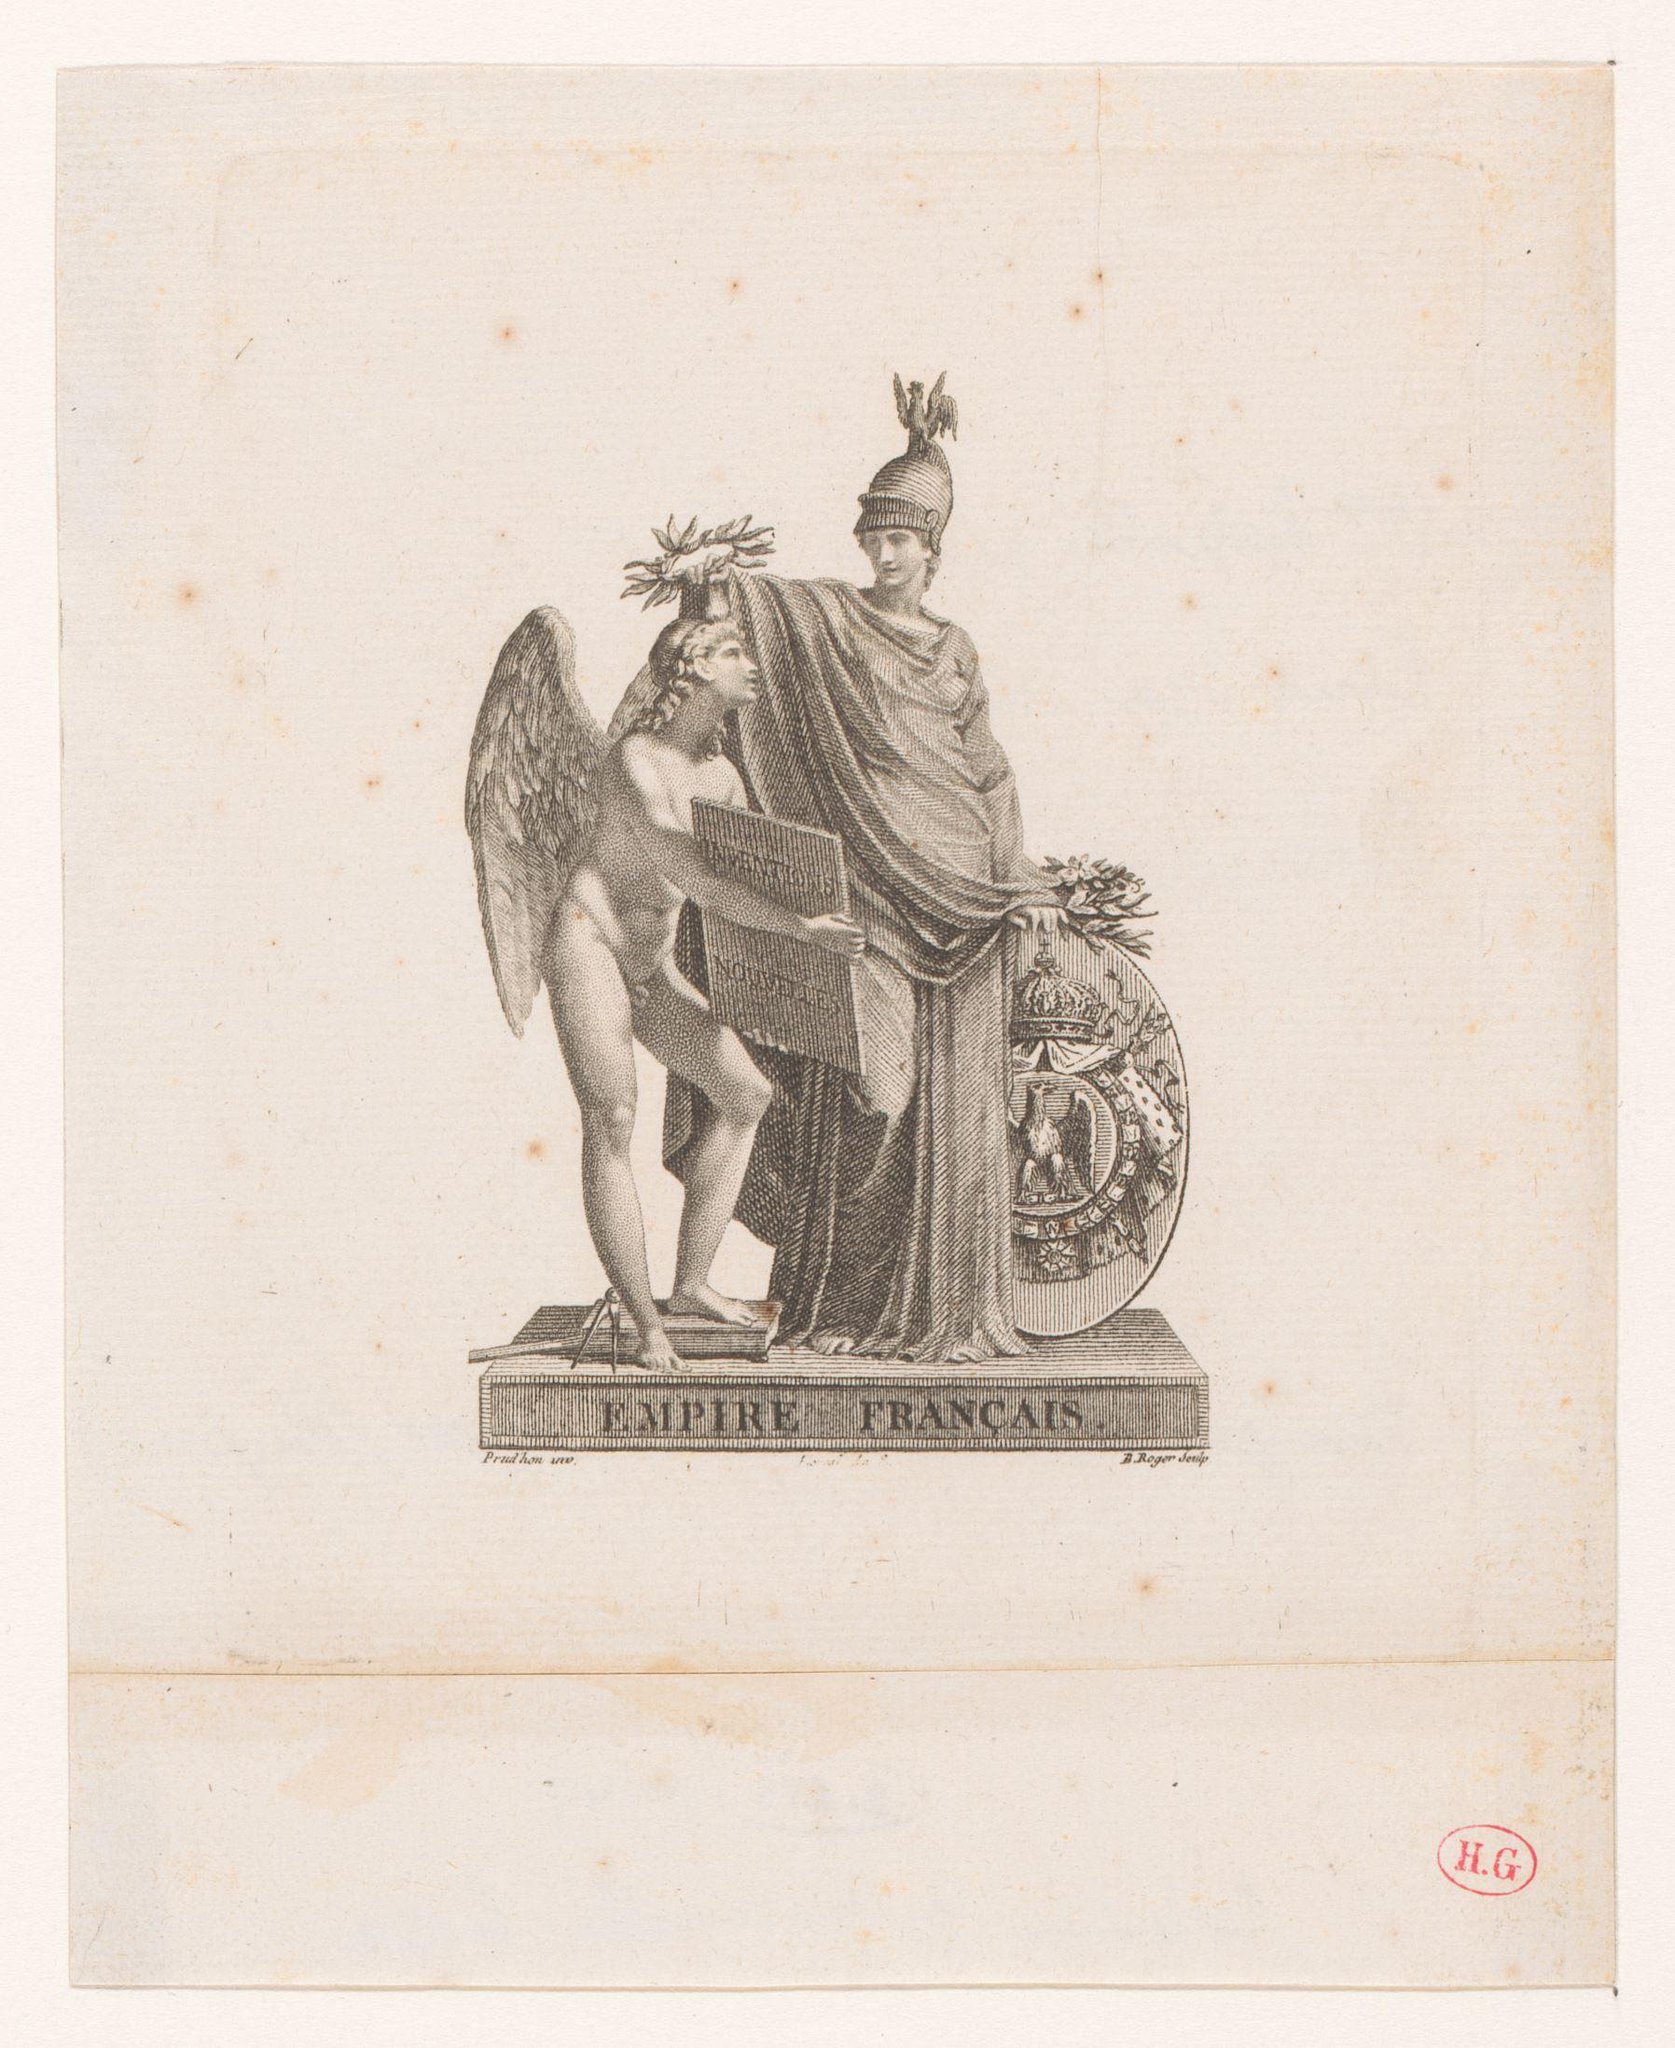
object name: print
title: Briefhoofd voor octrooi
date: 1804-1815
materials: paper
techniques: engraving, etching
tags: personifications of countries, nations, states, districts, etc., genius, letter, envelope, invention, discovery ~ science and technology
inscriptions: collector's mark: Lugt 2228, collector's mark: Lugt 1311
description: Frankrijk kroont een Genie die een bord vasthoudt met daarop de woorden "Inventions Nouvelles".